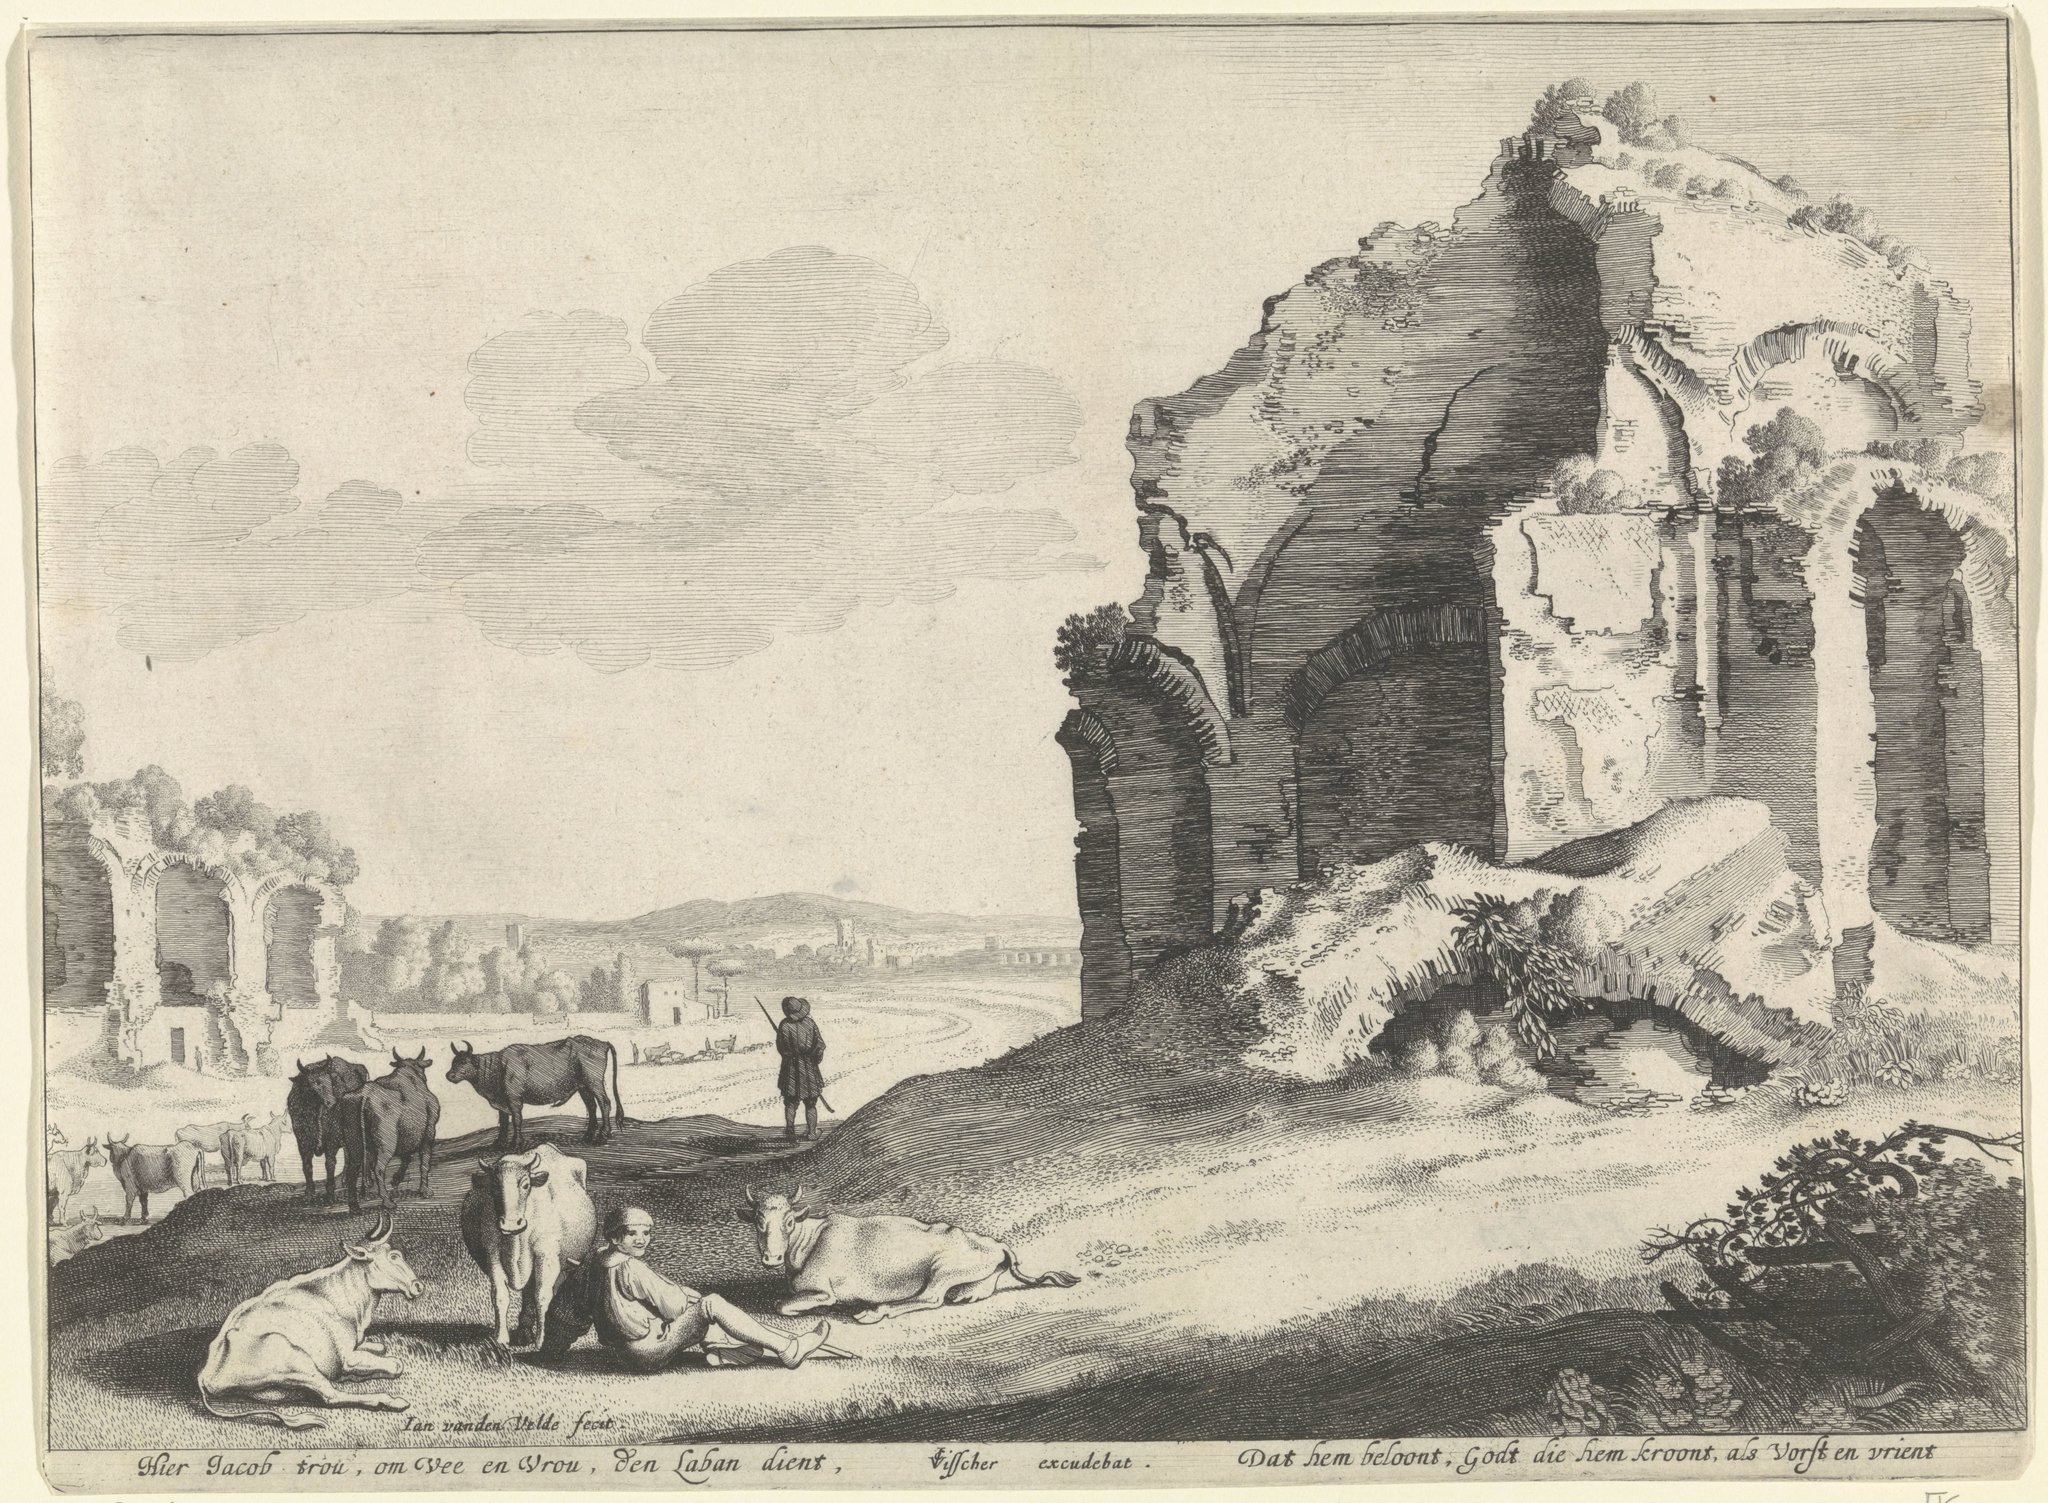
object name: print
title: Jacob als herder in een landschap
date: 1603-1652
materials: paper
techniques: engraving, etching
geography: amsterdam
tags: jacob works as a herdsman for seven years in exchange for rachel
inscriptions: collector's mark: Lugt 964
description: Jacob werkend als herder in ruil voor Rachel, in een landschap met een ruïne.